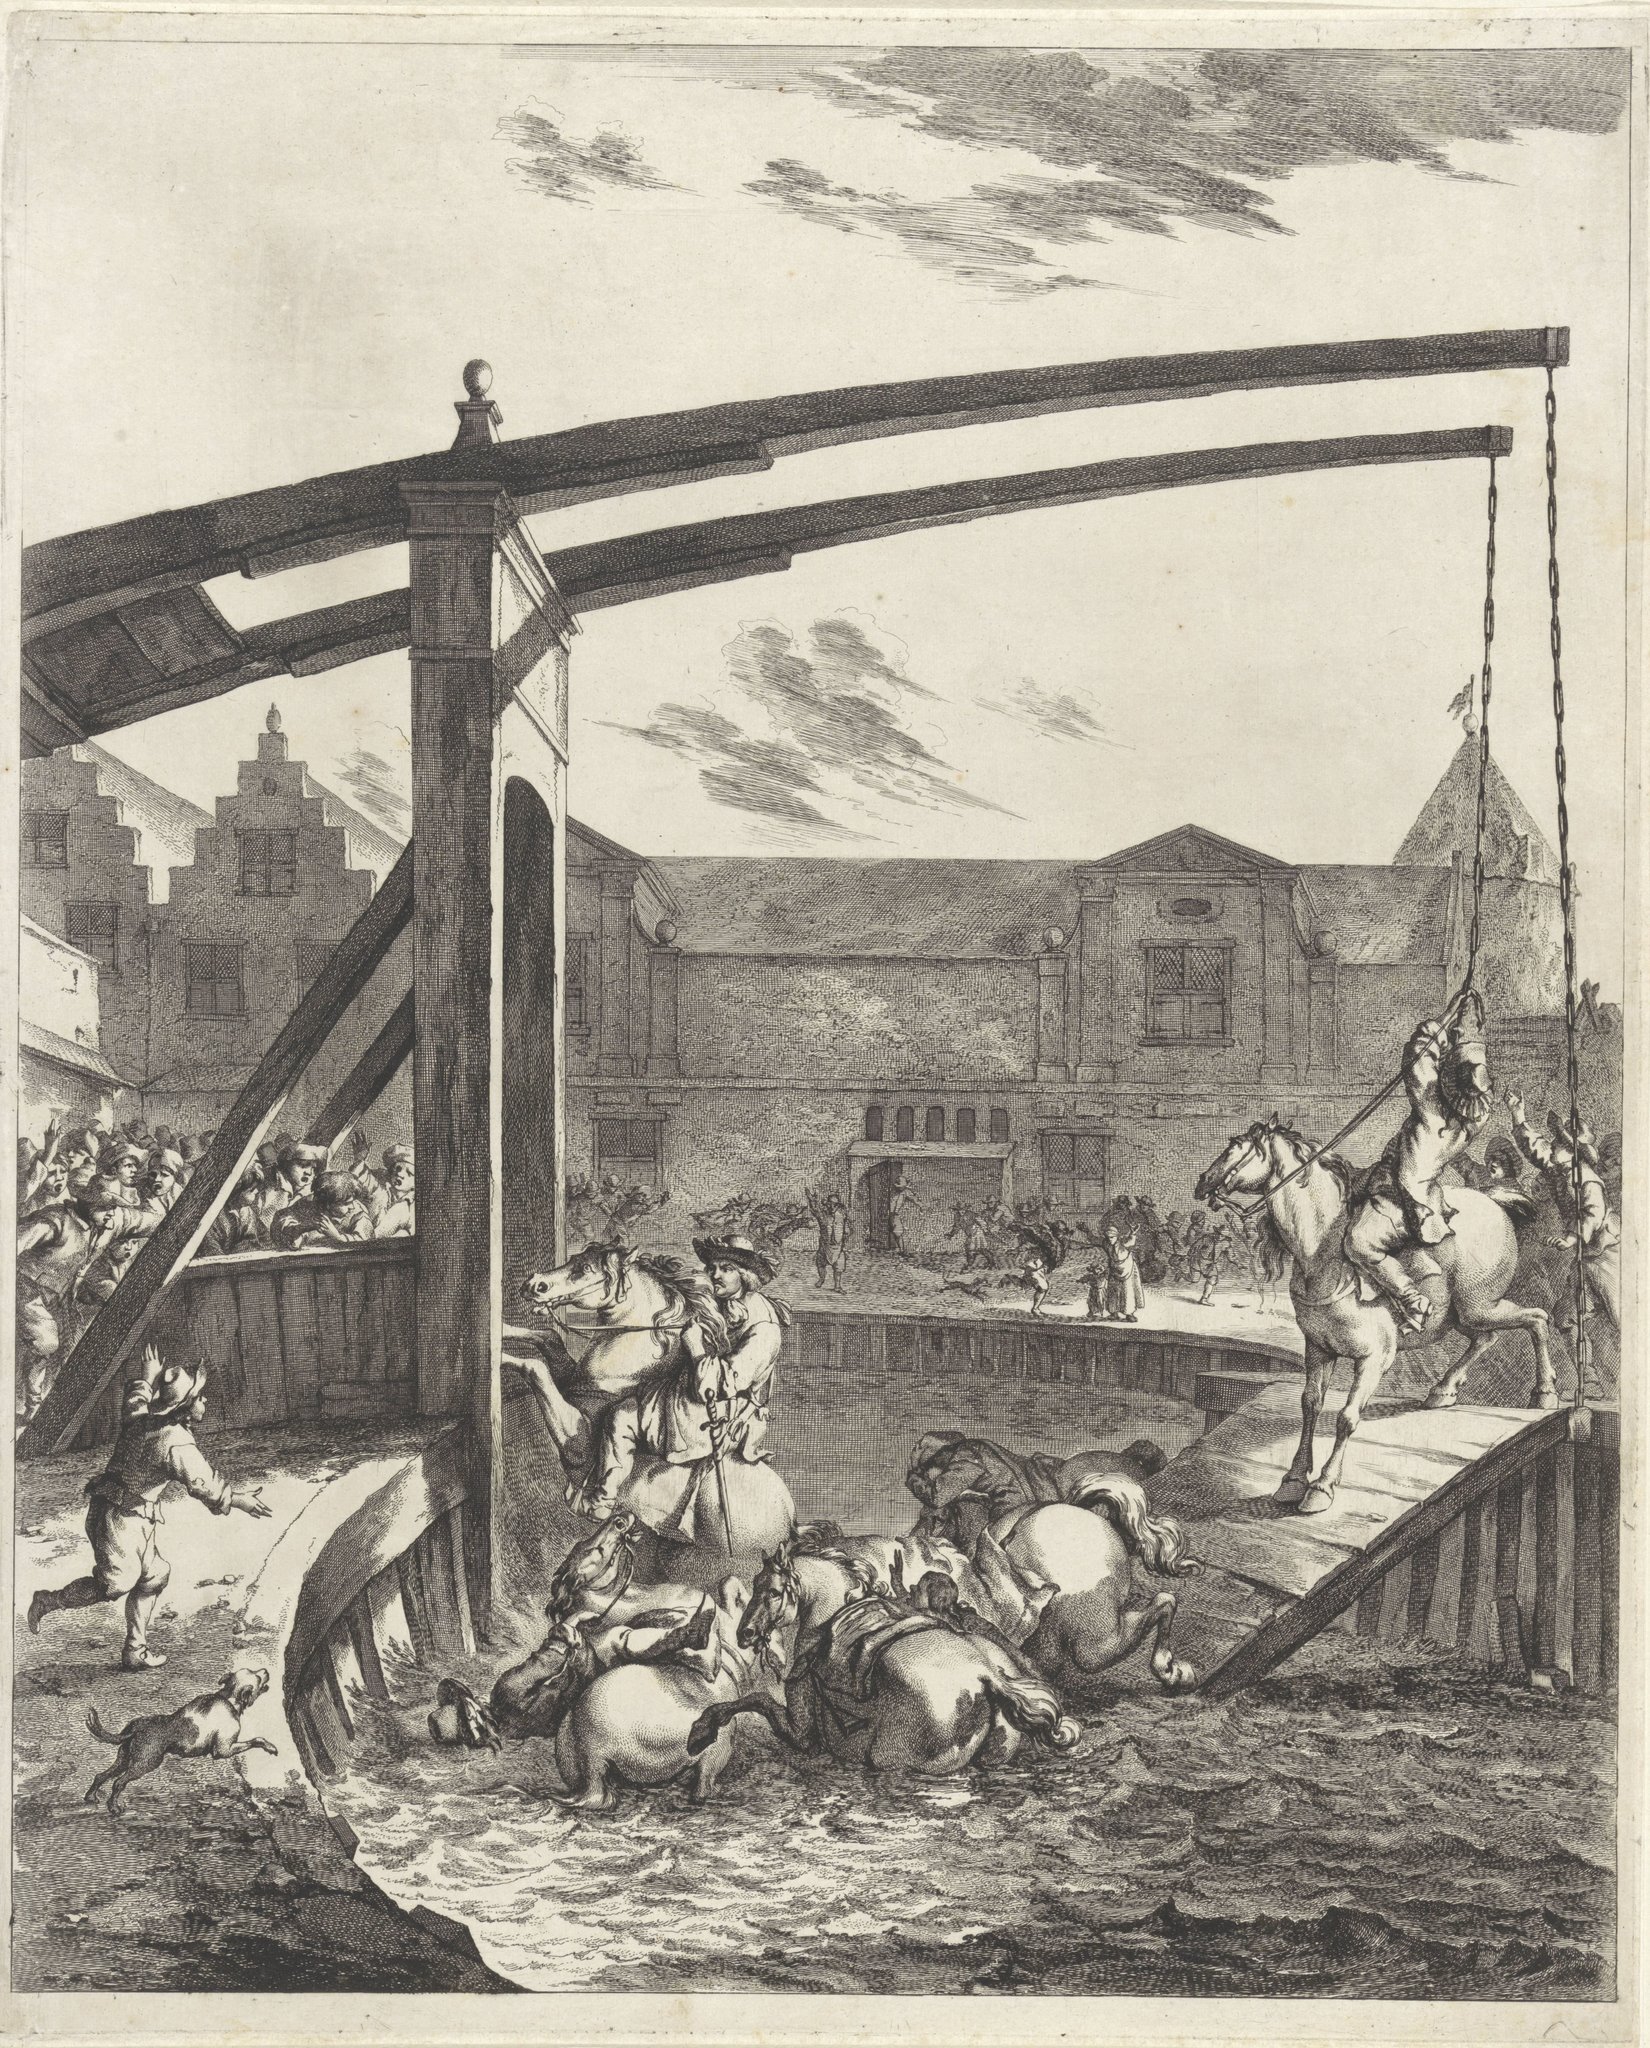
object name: print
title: Ongeluk van graaf Johan Maurits op de brug van Franeker, 1665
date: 1665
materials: paper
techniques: etching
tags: earl, johan maurits graaf van nassau-siegen, collapsing building, bridge, accident with horse (or kindred animal)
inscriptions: collector's mark: Lugt 240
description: Ongeluk van graaf Johan Maurits op de brug van Franeker, 6 januari 1665. De ophaalbrug waar de graaf met zijn gevolg overheen rijdt stort in en de graaf valt in het water.